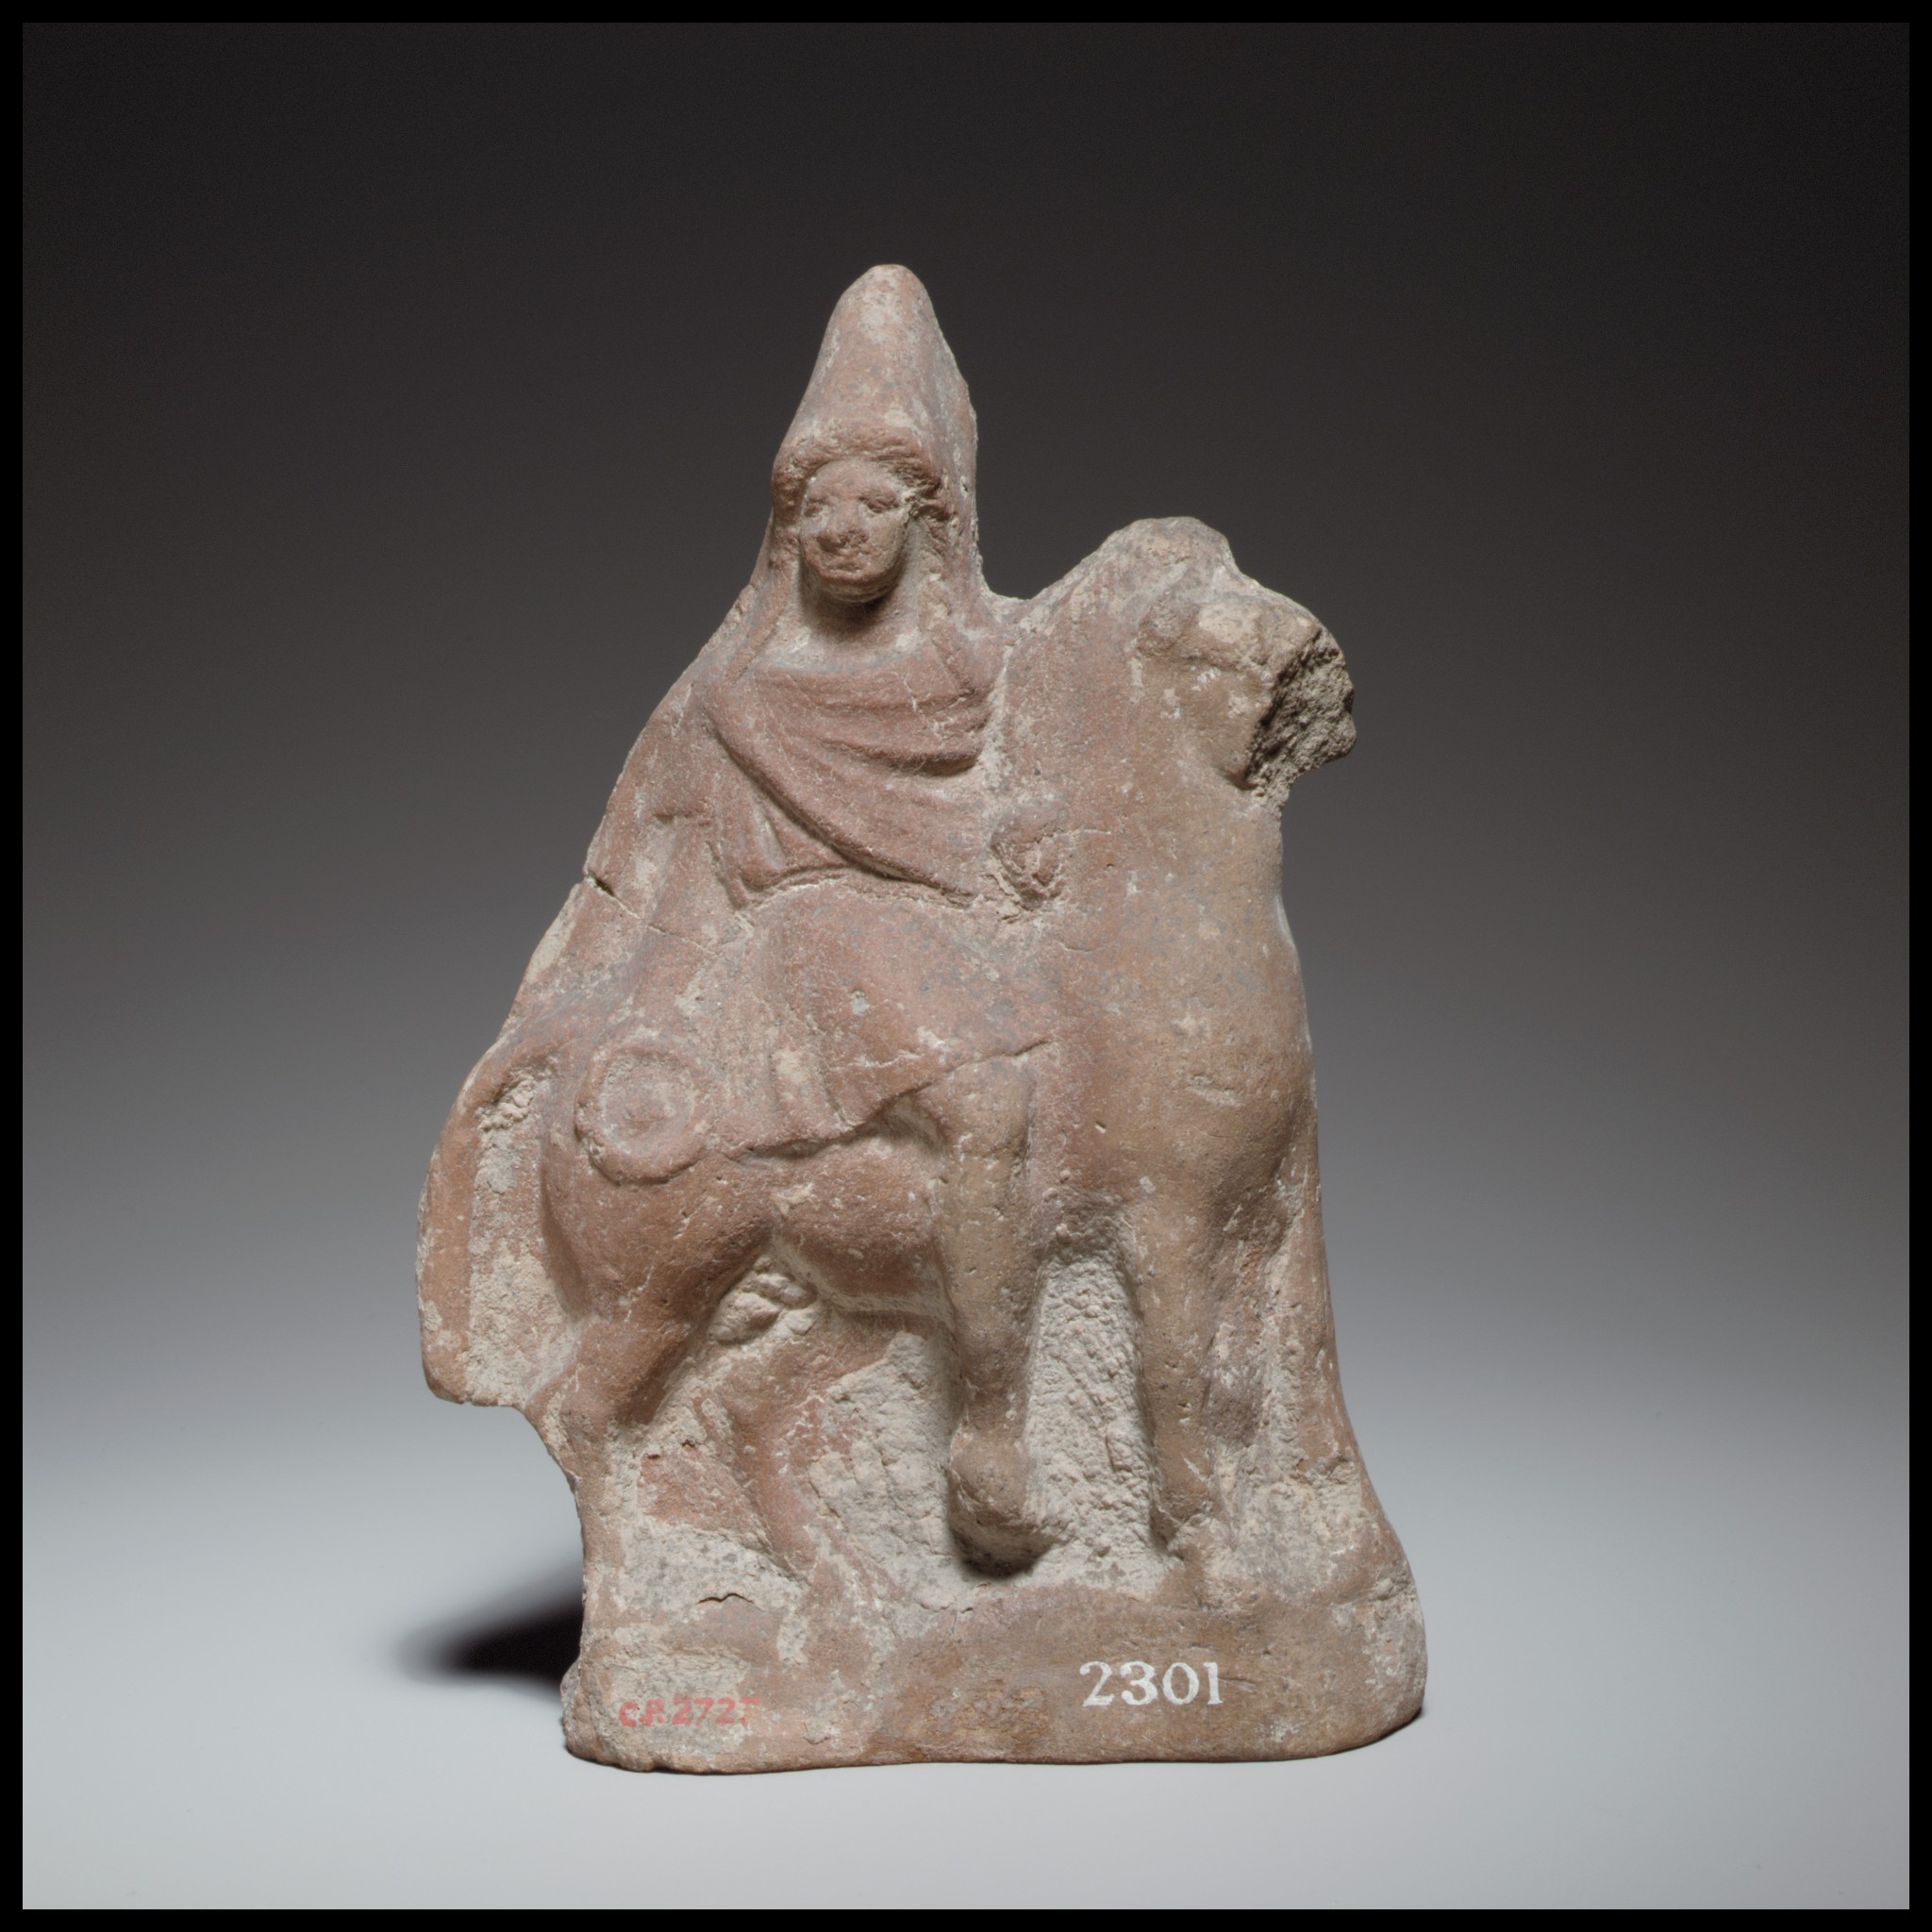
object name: statuette of a votary, phrygian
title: Terracotta statuette of a horse and rider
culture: cypriot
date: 300-201 BCE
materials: terracotta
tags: human figures,horses